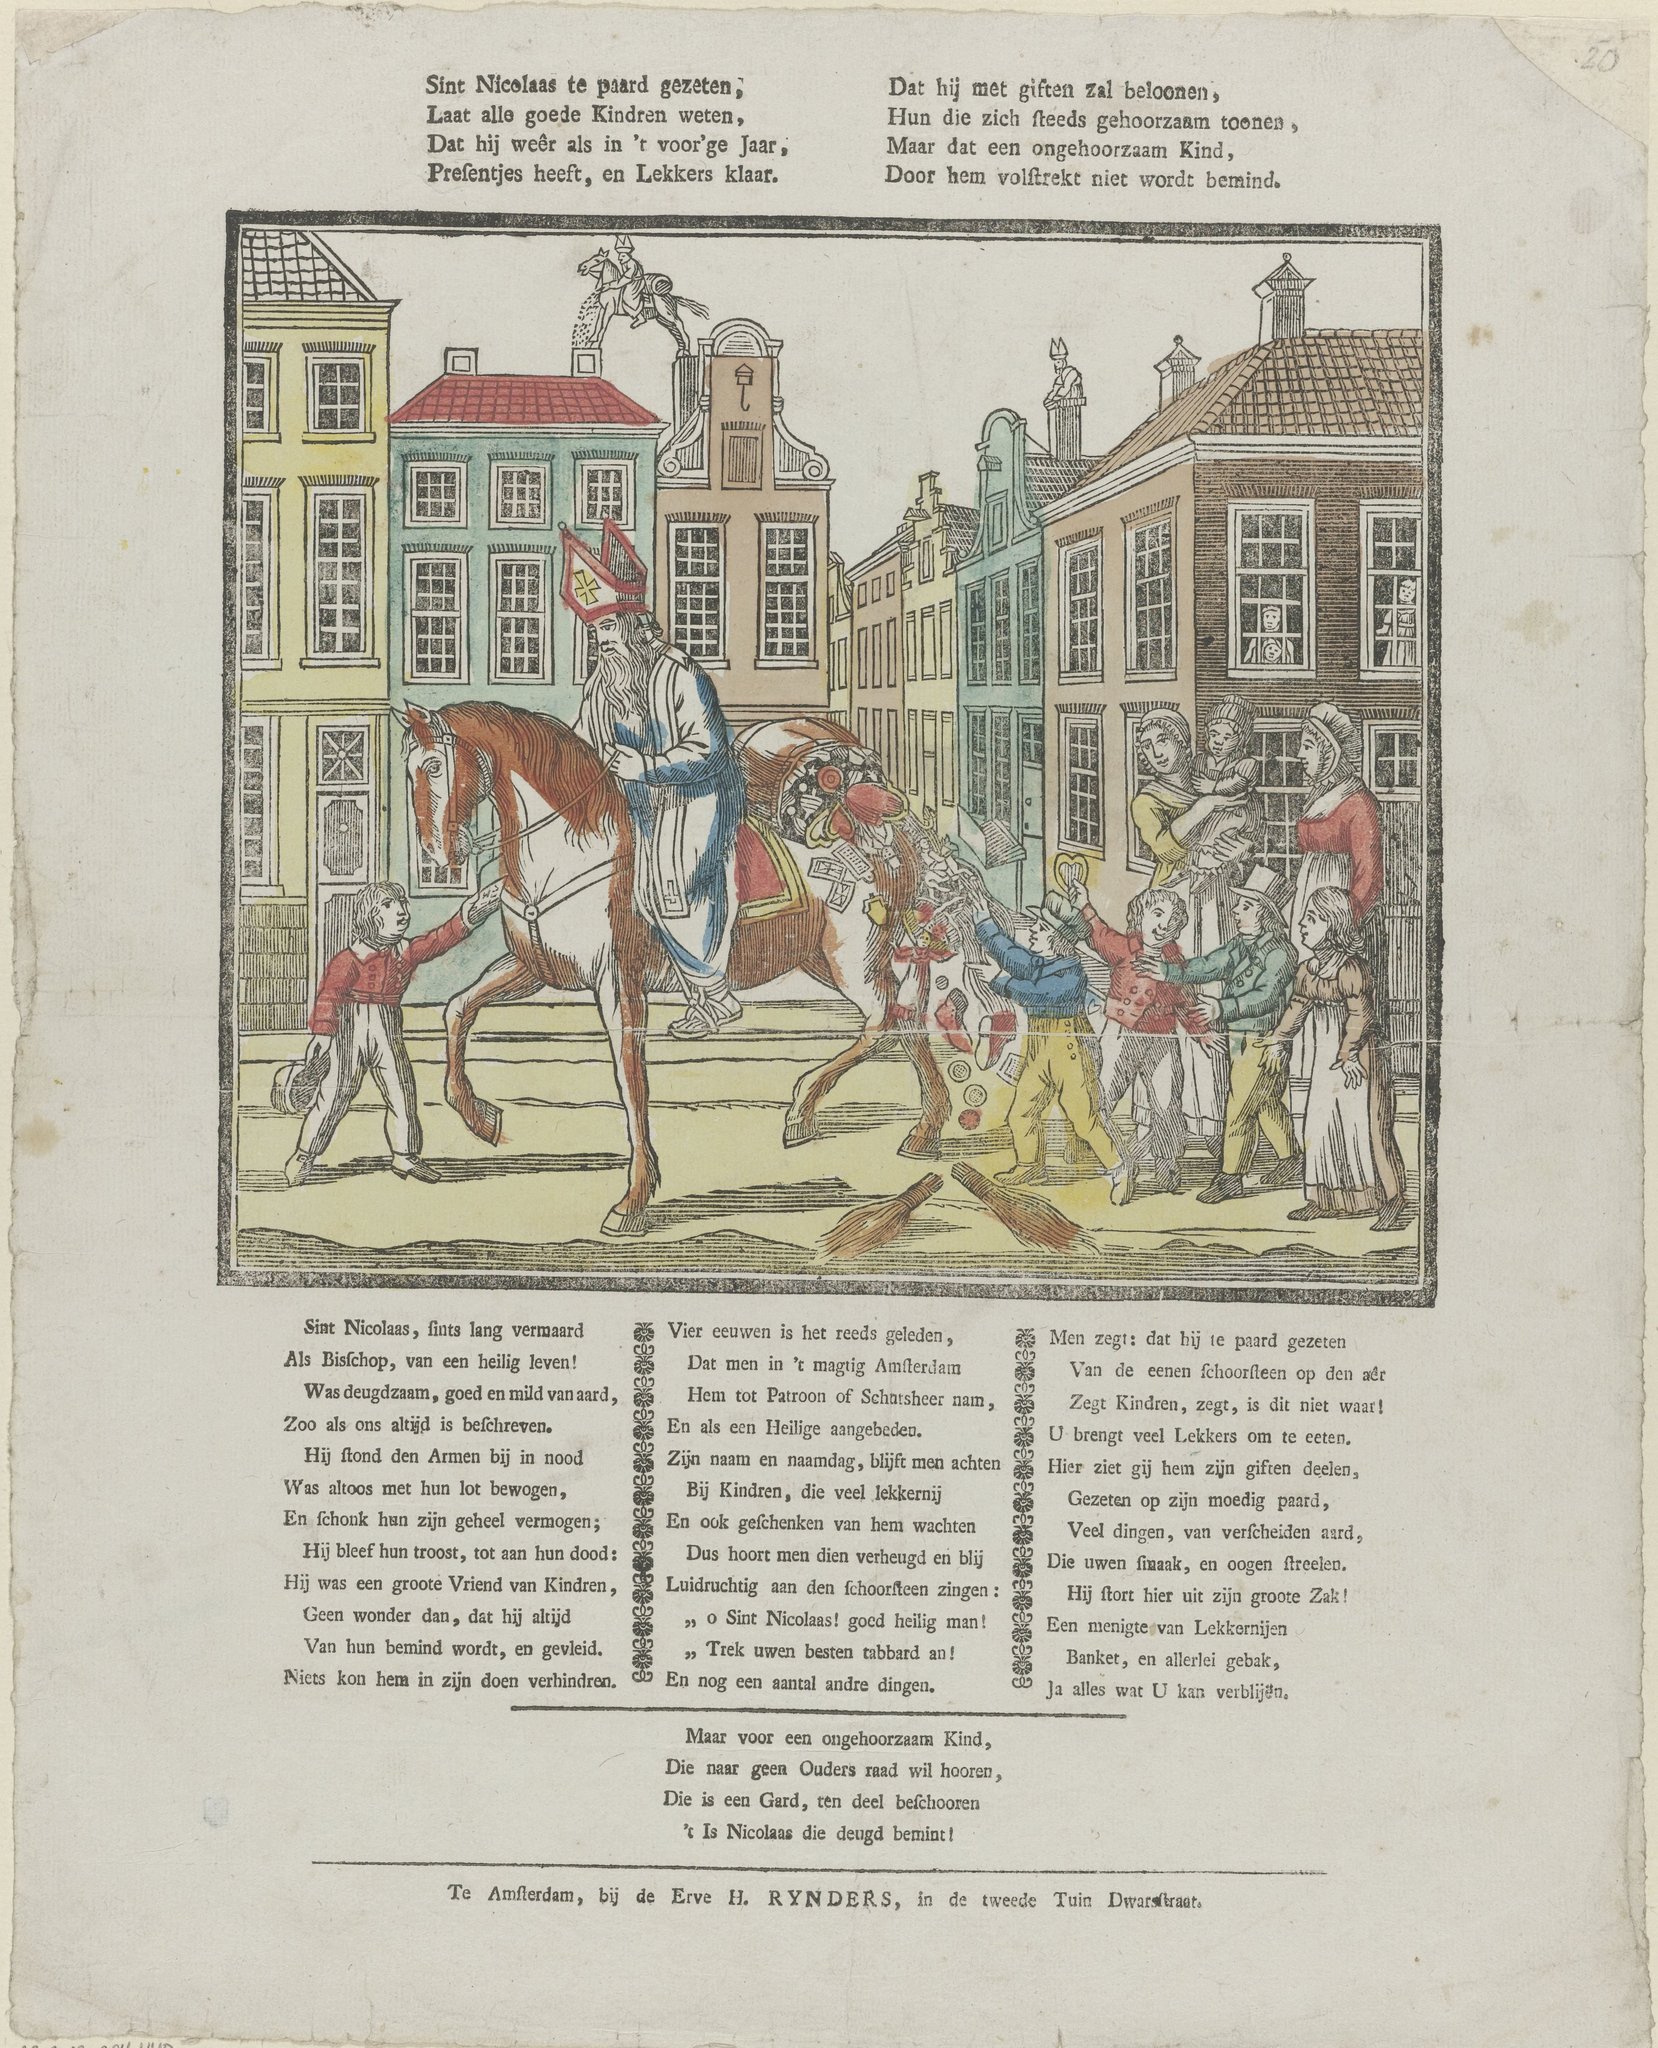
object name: print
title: Sint Nicolaas te paard gezeten, / Laat alle goede kindren weten [(...)]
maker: Anonymous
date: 1831-1854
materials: paper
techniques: colour, letterpress printing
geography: netherlands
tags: the bishop nicholas of myra (or bari); possible attributes: anchor, boat, three golden balls (on a book), three purses, three children in a tub, three maidens, festivities on st. nicholas (eve) (december 5)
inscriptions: collector's mark: Lugt 2760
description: Blad met een grote voorstelling van Sint Nicolaas te paard, die snoep en speelgoed uitdeelt aan kinderen op straat. Op de achtergrond Sint Nicolaas te paard op het dak. In de ondermarge een vers in vier kolommen.